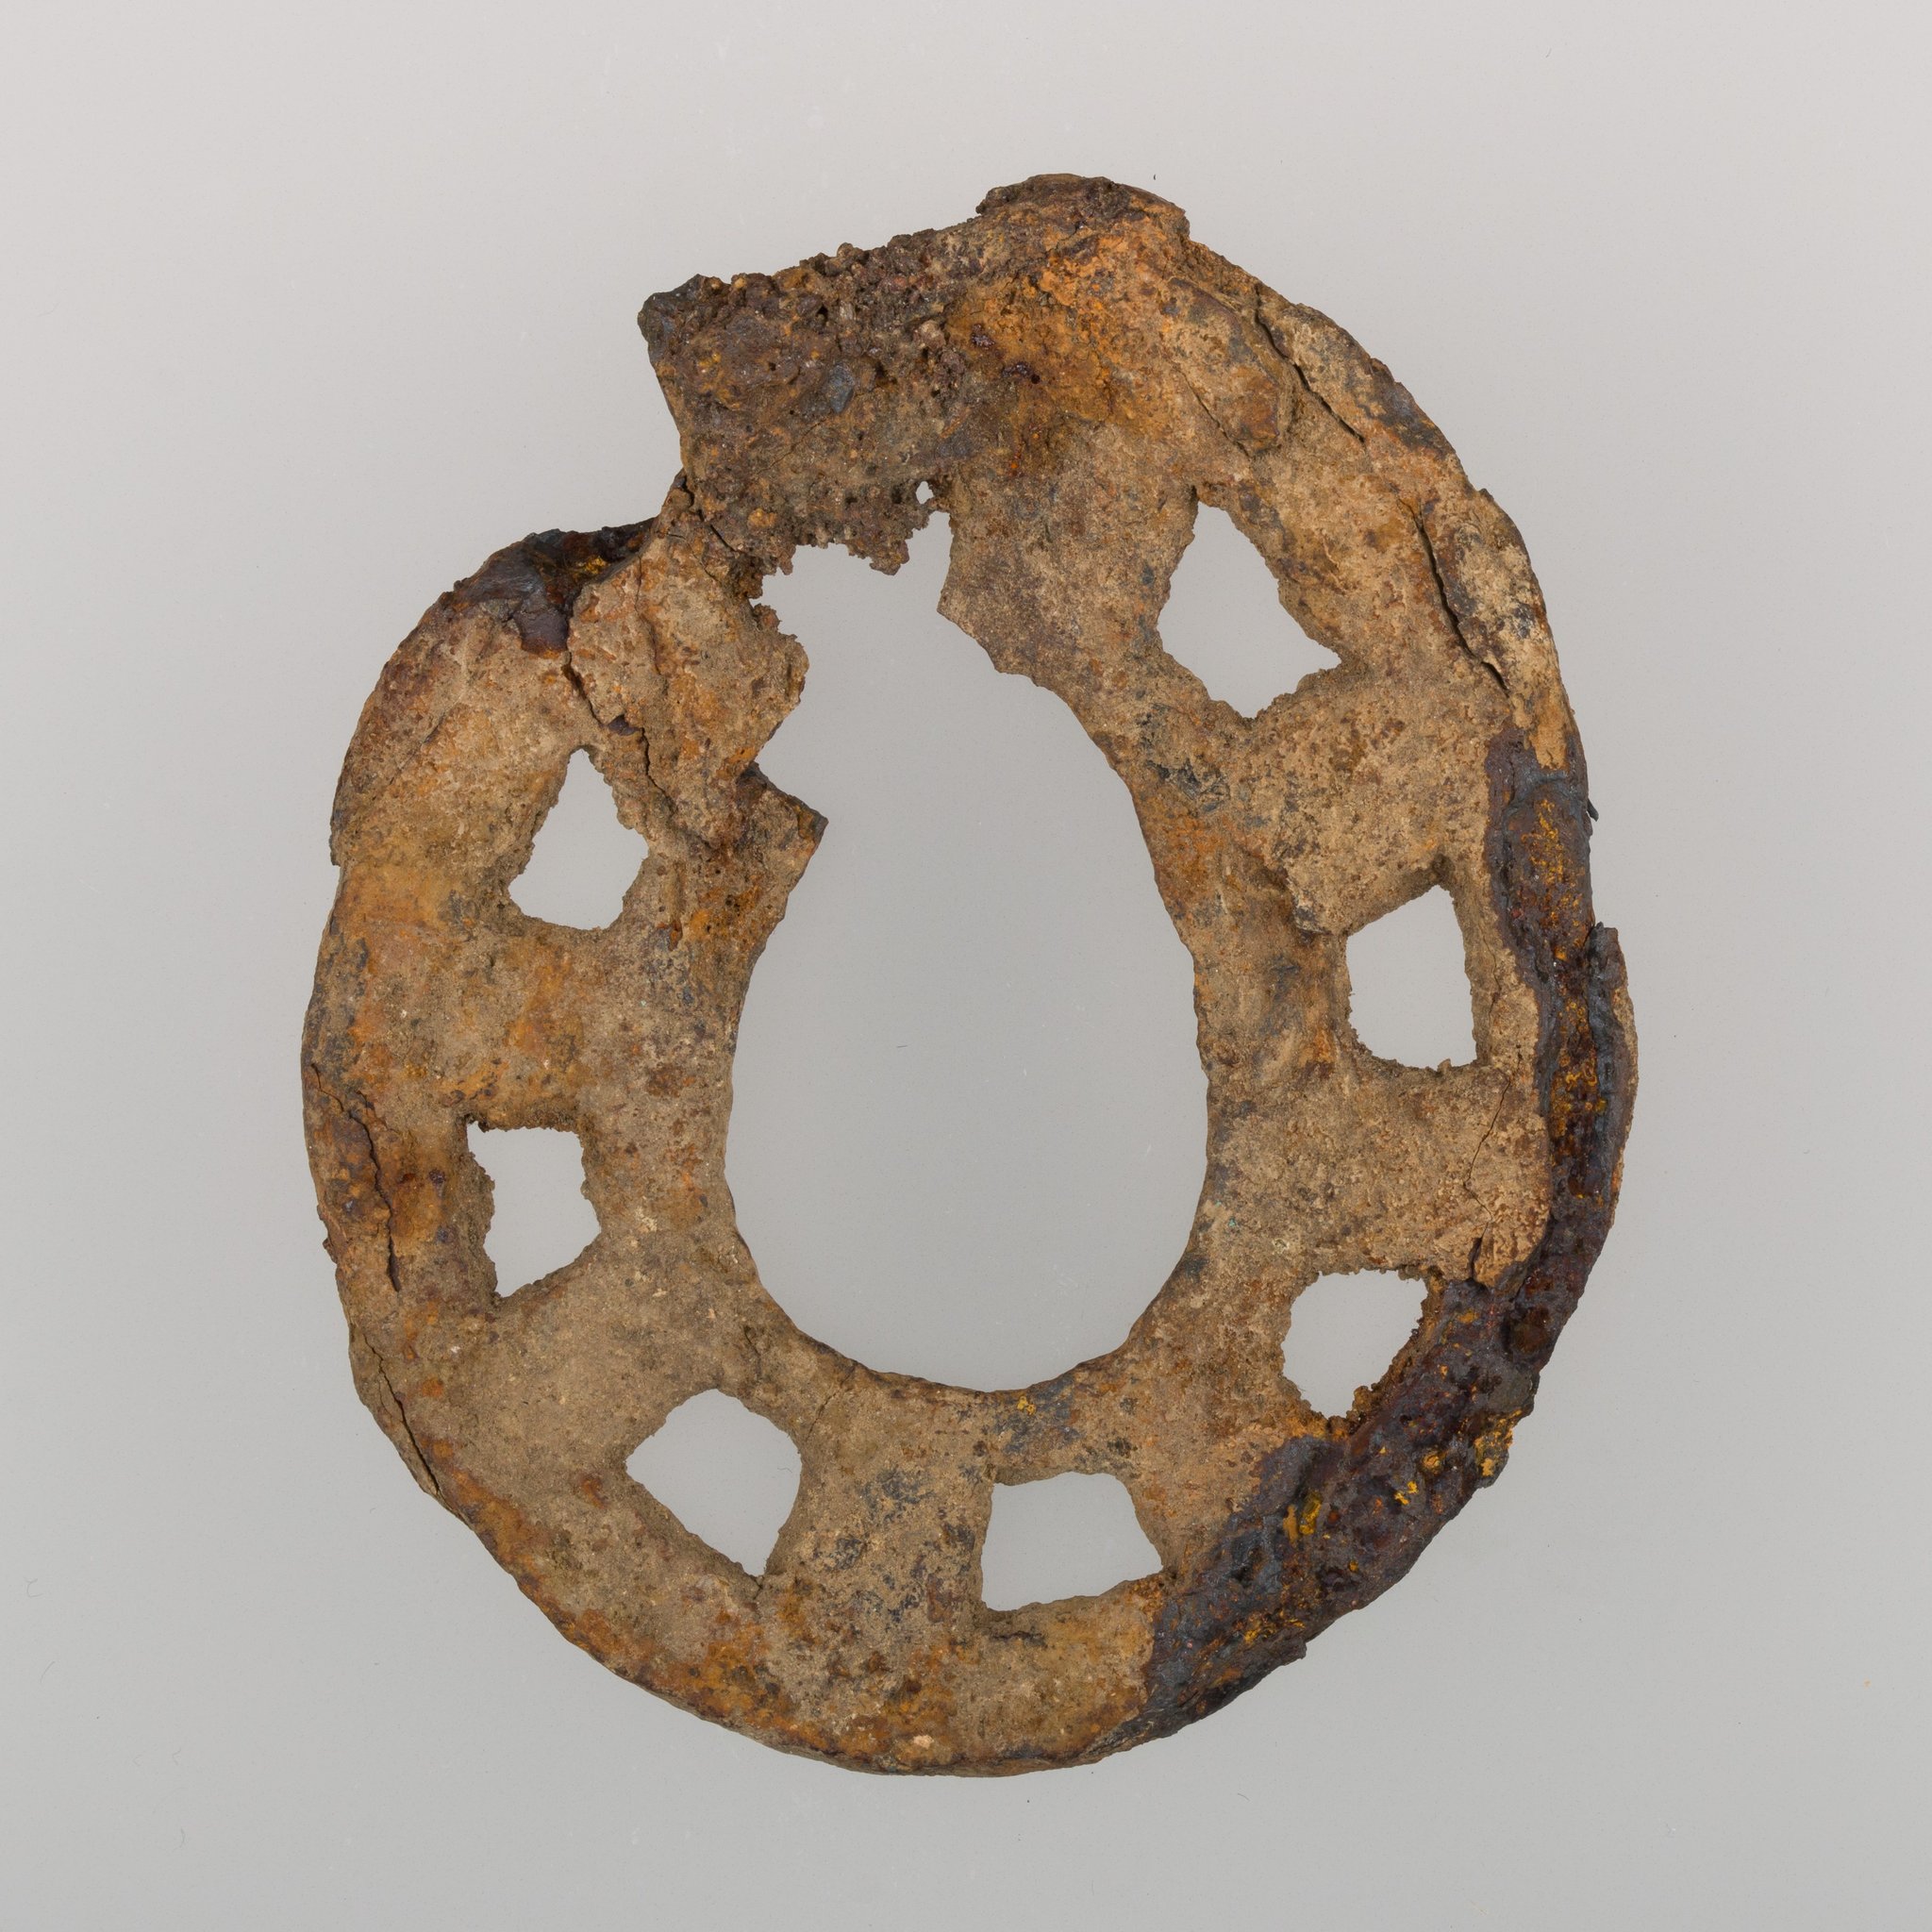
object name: sword guard tsuba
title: Sword Guard (Tsuba)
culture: japanese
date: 201-300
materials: iron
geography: japan